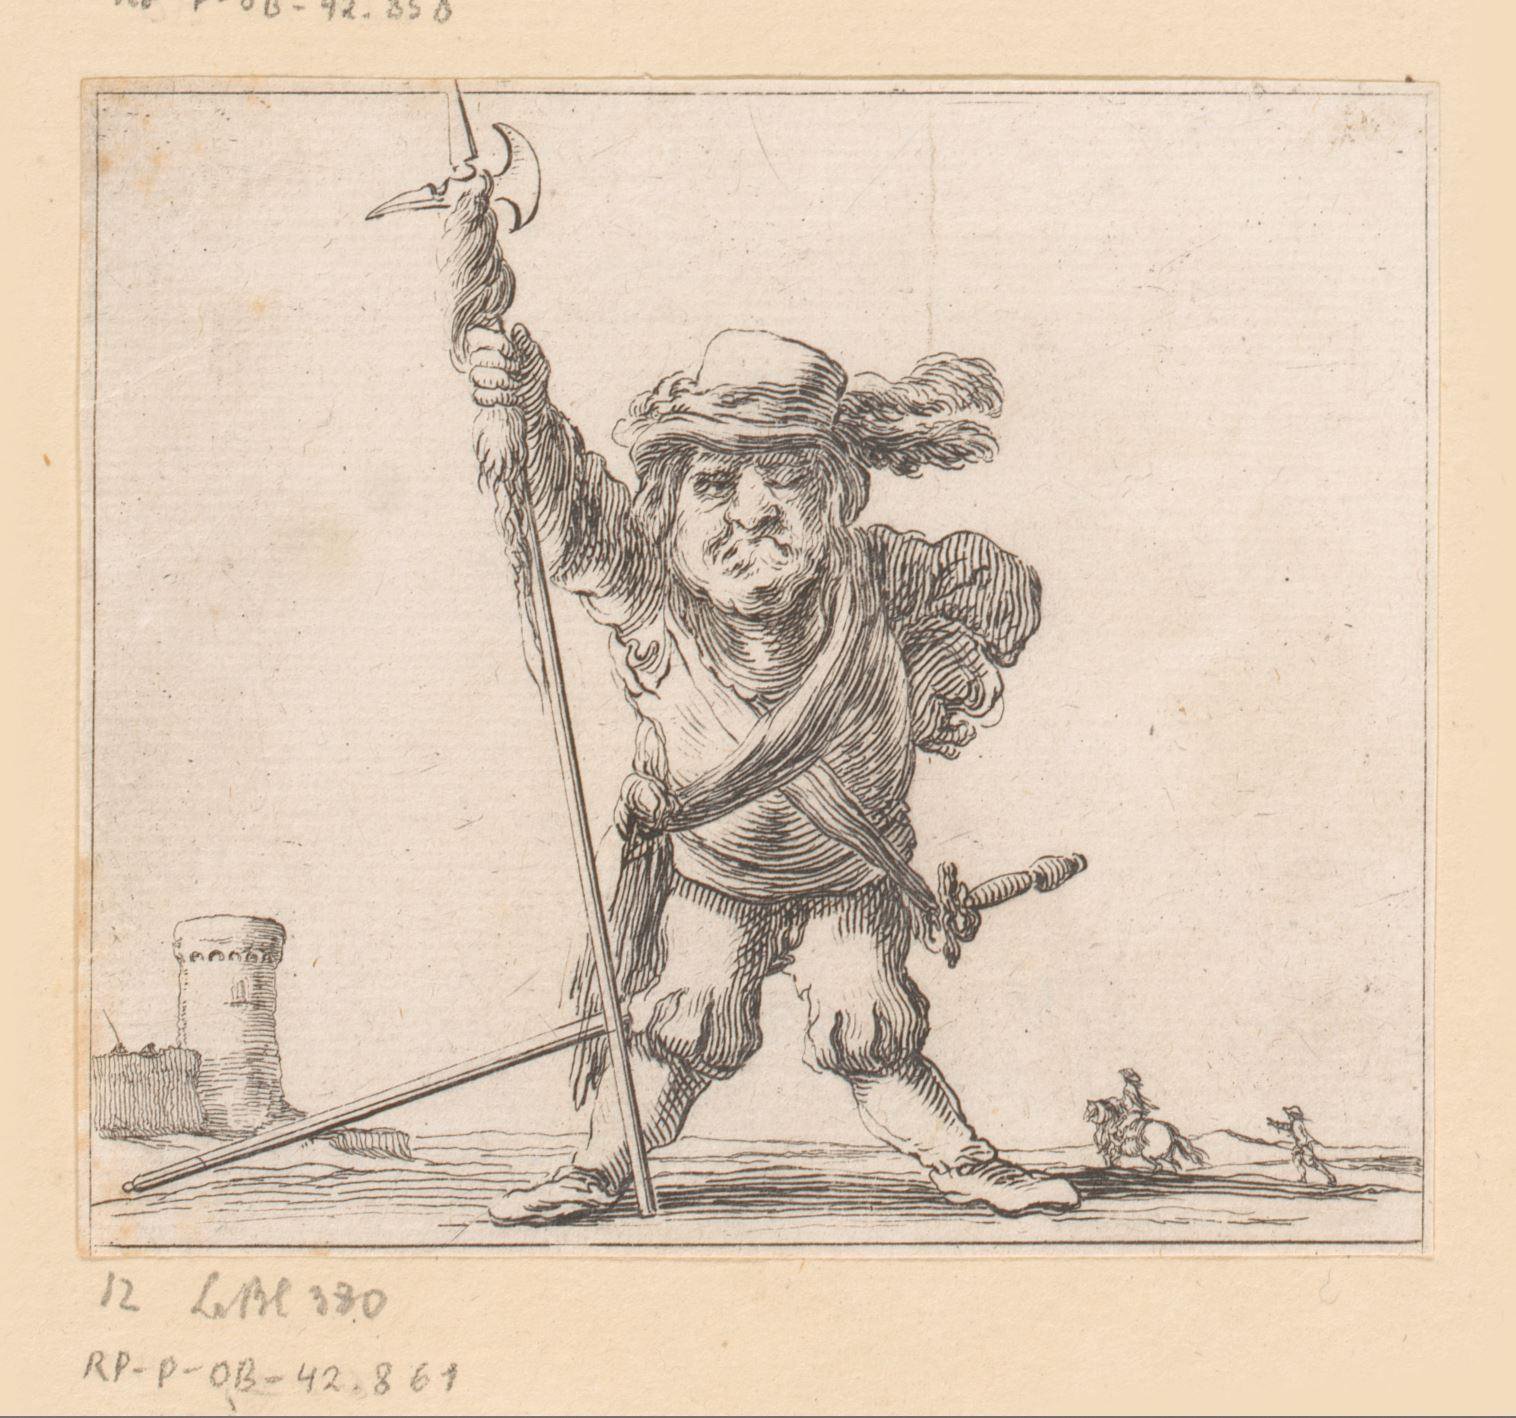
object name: print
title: Serie met karikaturale figuren, zonder toeschrijving aan Collignon of de la Bella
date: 1620-1687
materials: paper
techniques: engraving, etching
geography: italy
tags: caricatures (human types), adult man, helved weapons, polearms (for striking, hacking, thrusting): halberd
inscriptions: collector's mark: Lugt 240